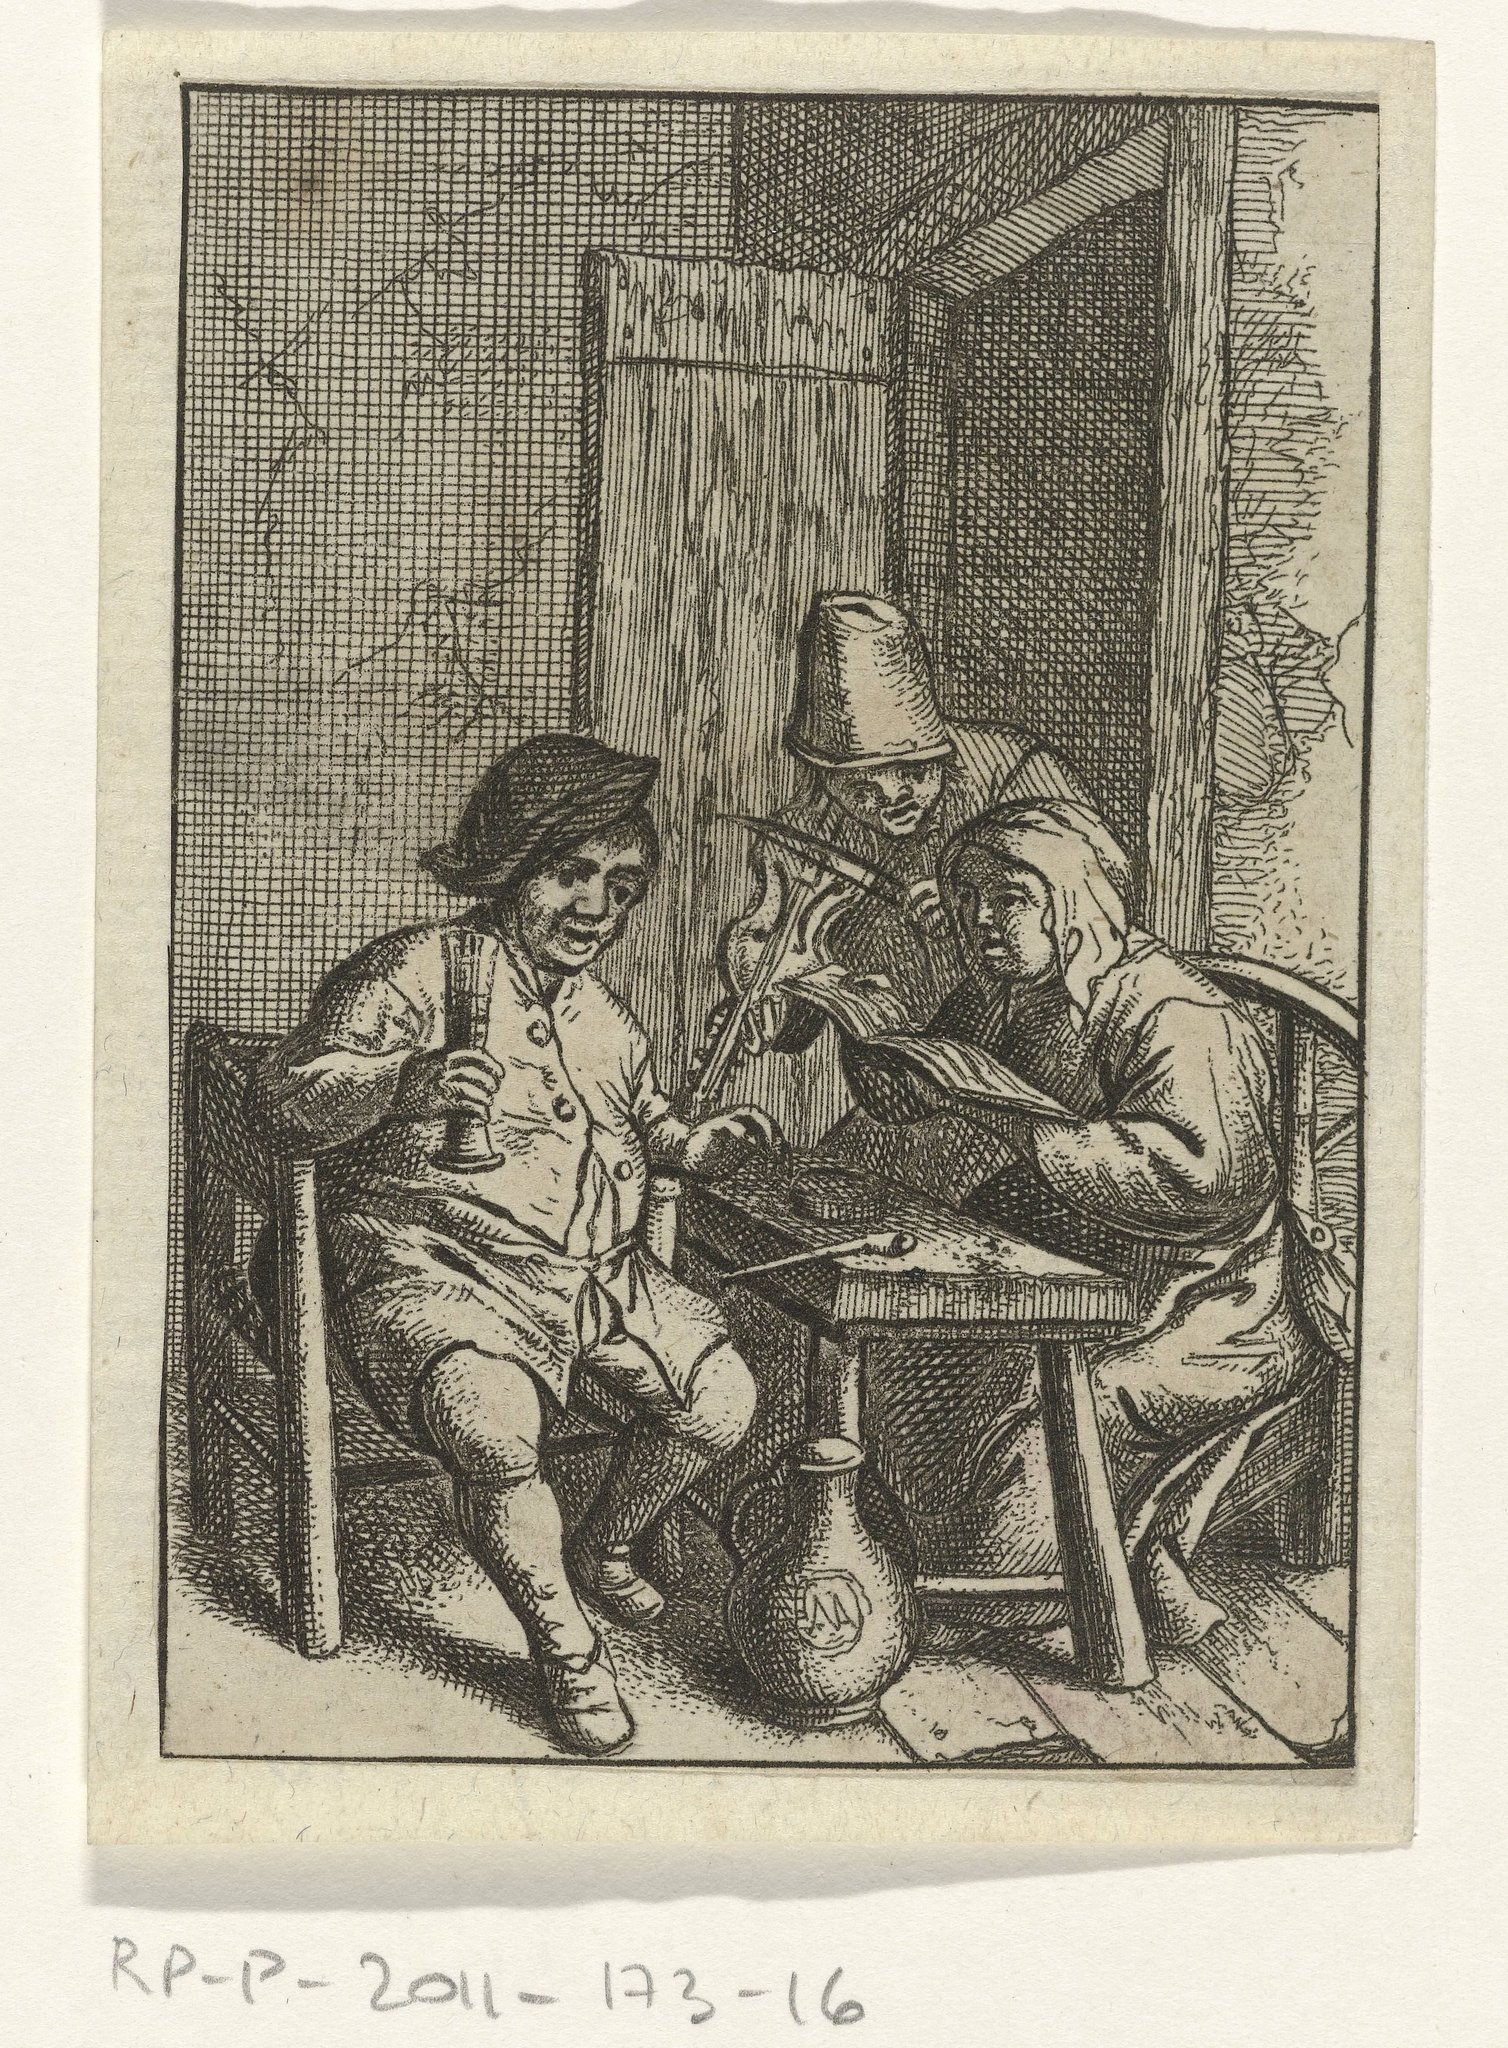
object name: print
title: Het concert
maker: Anonymous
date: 1653-1750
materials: paper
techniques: etching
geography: europe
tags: instrumental and vocal music together, violin, fiddle, printed edition of musical score, instrumental popular music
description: Na de overname van de firma Niemeyer door British American Tabacco Group besloot deze de collectie van het Niemeyer Tabaksmuseum af te stoten. De beheerder van de collectie, het Noordelijk Scheepvaartmuseum, organiseerde in januari 2011 open dagen voor musea waar deze hun voorkeuren voor collectieonderdelen kenbaar konden maken. De objecten zijn getaxeerd door medewerkers van Christie's en vervolgens ter overname aangeboden aan de belangstellende musea. Het Rijksprentenkabinet koos 46 prenten uit de collectie tegen door de medewerkers van Christie's vastgestelde waarde. [H. Leeflang, 2011-06-09]